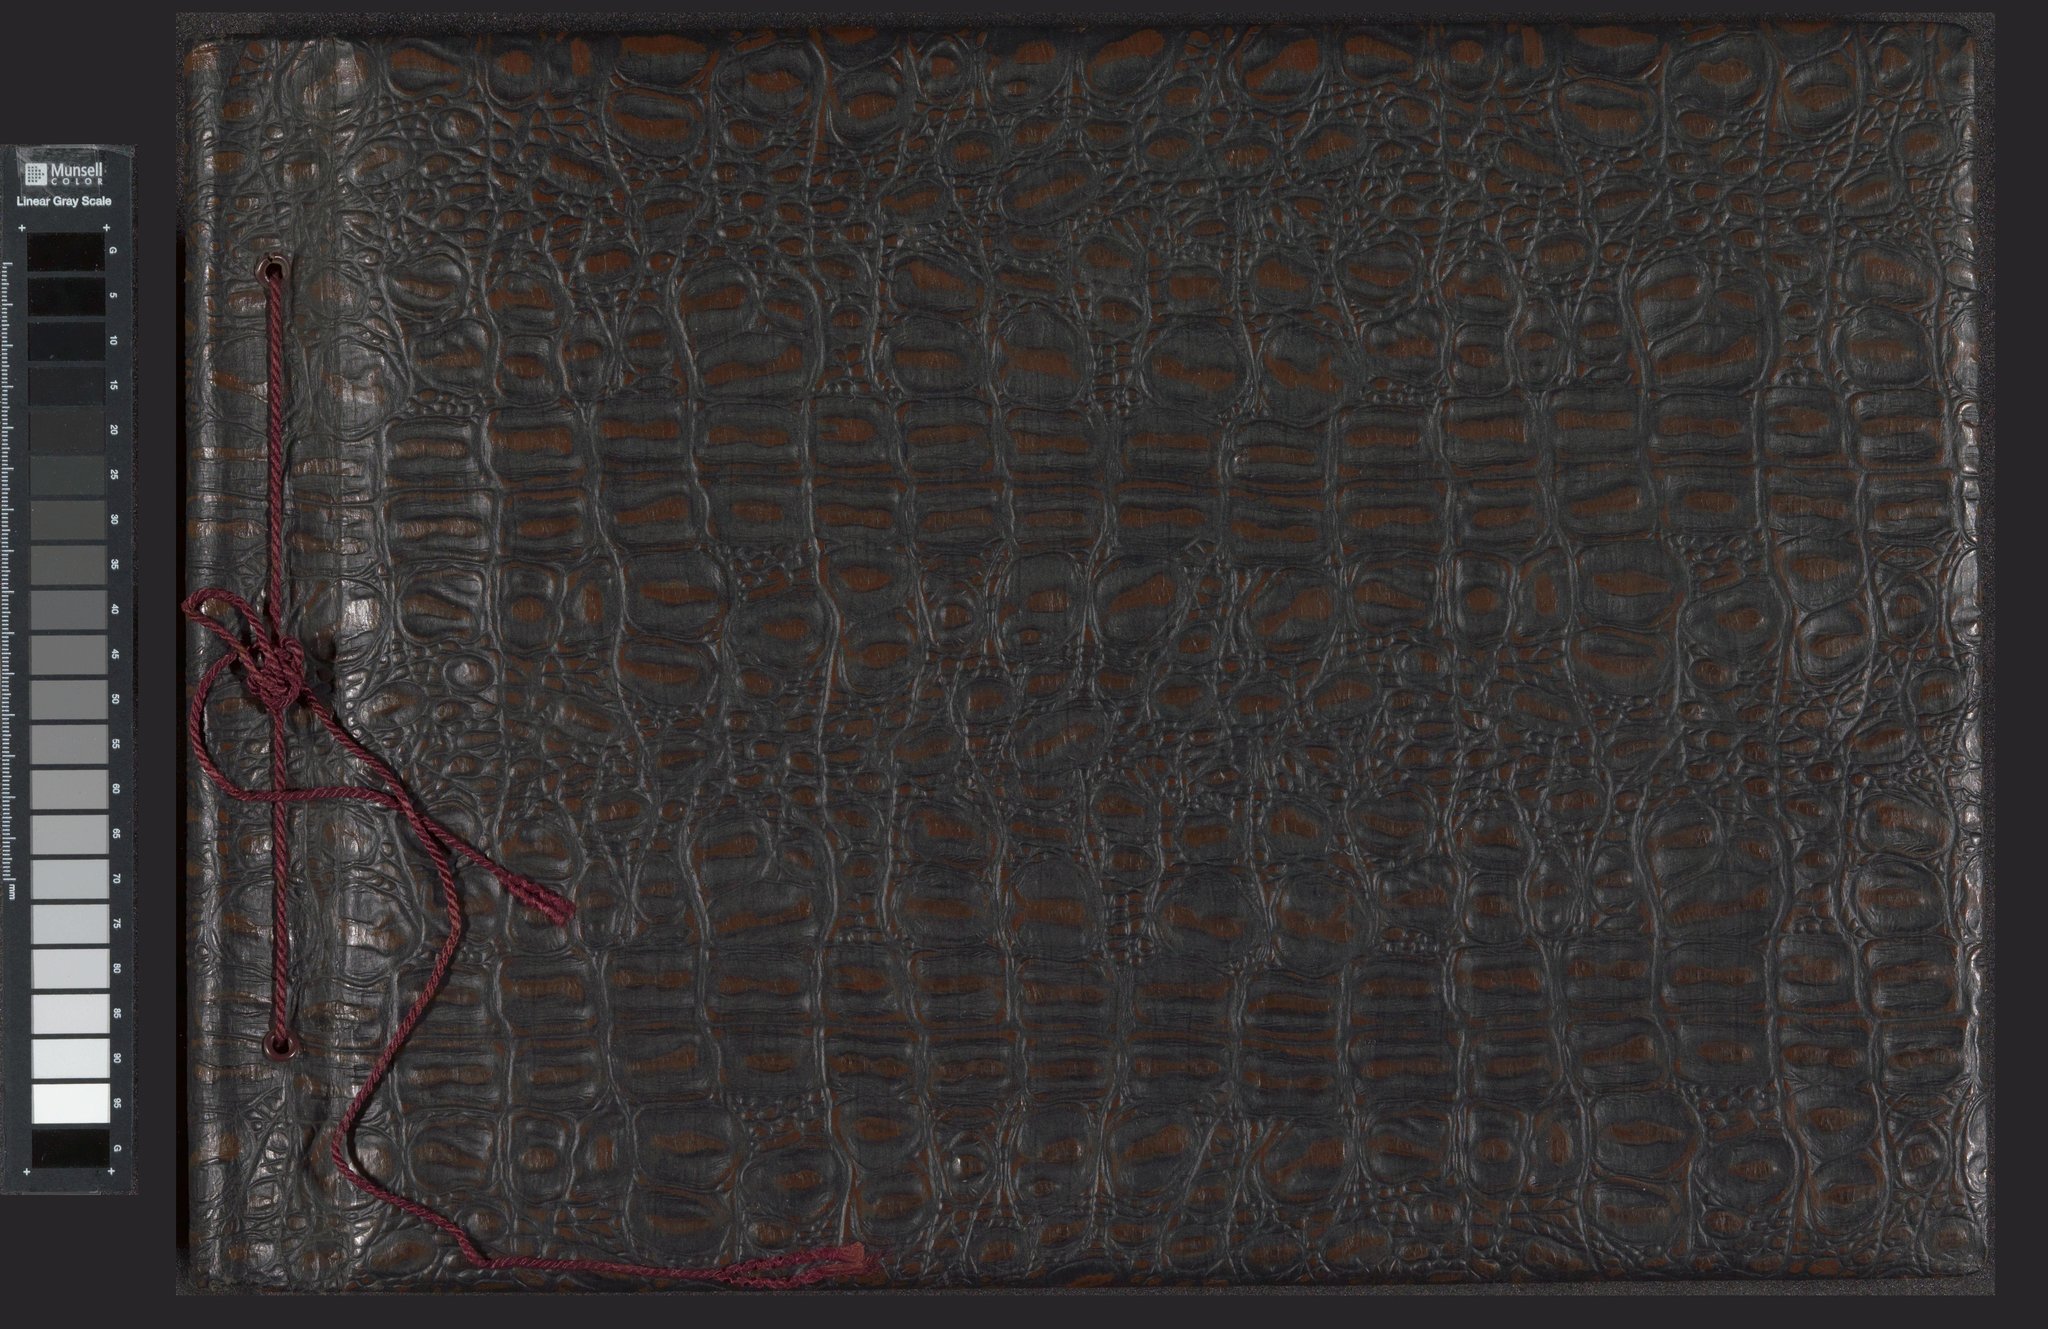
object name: slip in album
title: Herinneringsalbum voor F.J. Junius, vertrekkend resident van Lampong (Zuid-Sumatra)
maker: Anonymous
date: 1932-1933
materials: cardboard, paper, leather, metal, photographic support, fiber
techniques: gelatin silver print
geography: dutch east indies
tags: administrative bodies, colonial government, police, dutch east indies, the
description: Fotoalbum in bruine omslag van bruin krokodillenleer. De rug is doorregen met een roodbruin koord. Het album bevat 22 bladen gescheiden door tussenvellen van pergamijn met in totaal 86 foto's, waarvan er 1 los werd aangetroffen. De afdrukken hebben een witte rand en zijn bevestigd met goudkleurige fotohoekjes. Elke foto heeft een handgeschreven bijschrift. Het album werd vermoedelijk aangeboden bij het afscheid van F.J. Junius, resident van Lampong (Zuid-Sumatra) van 1930 tot 1933. Afgebeeld zijn diverse politie- en brandweerkorpsen uit zijn district, veelal statige groepsportretten en in scène gezette 'actiefoto's' van schiet- en schermlessen, oefeningen, vrijetijdsbesteding en het verbaliseren van een chauffeur. Ook de onthulling van de zgn. 'Junius-bank' in Tandjongkarang op 21 mei 1921 komt in beeld. Op de laatste pagina reserveerde de fotograaf en albumsamensteller een plek voor zichzelf: de gewestelijke politiefotograaf van Lampong wiens naam onbekend is.